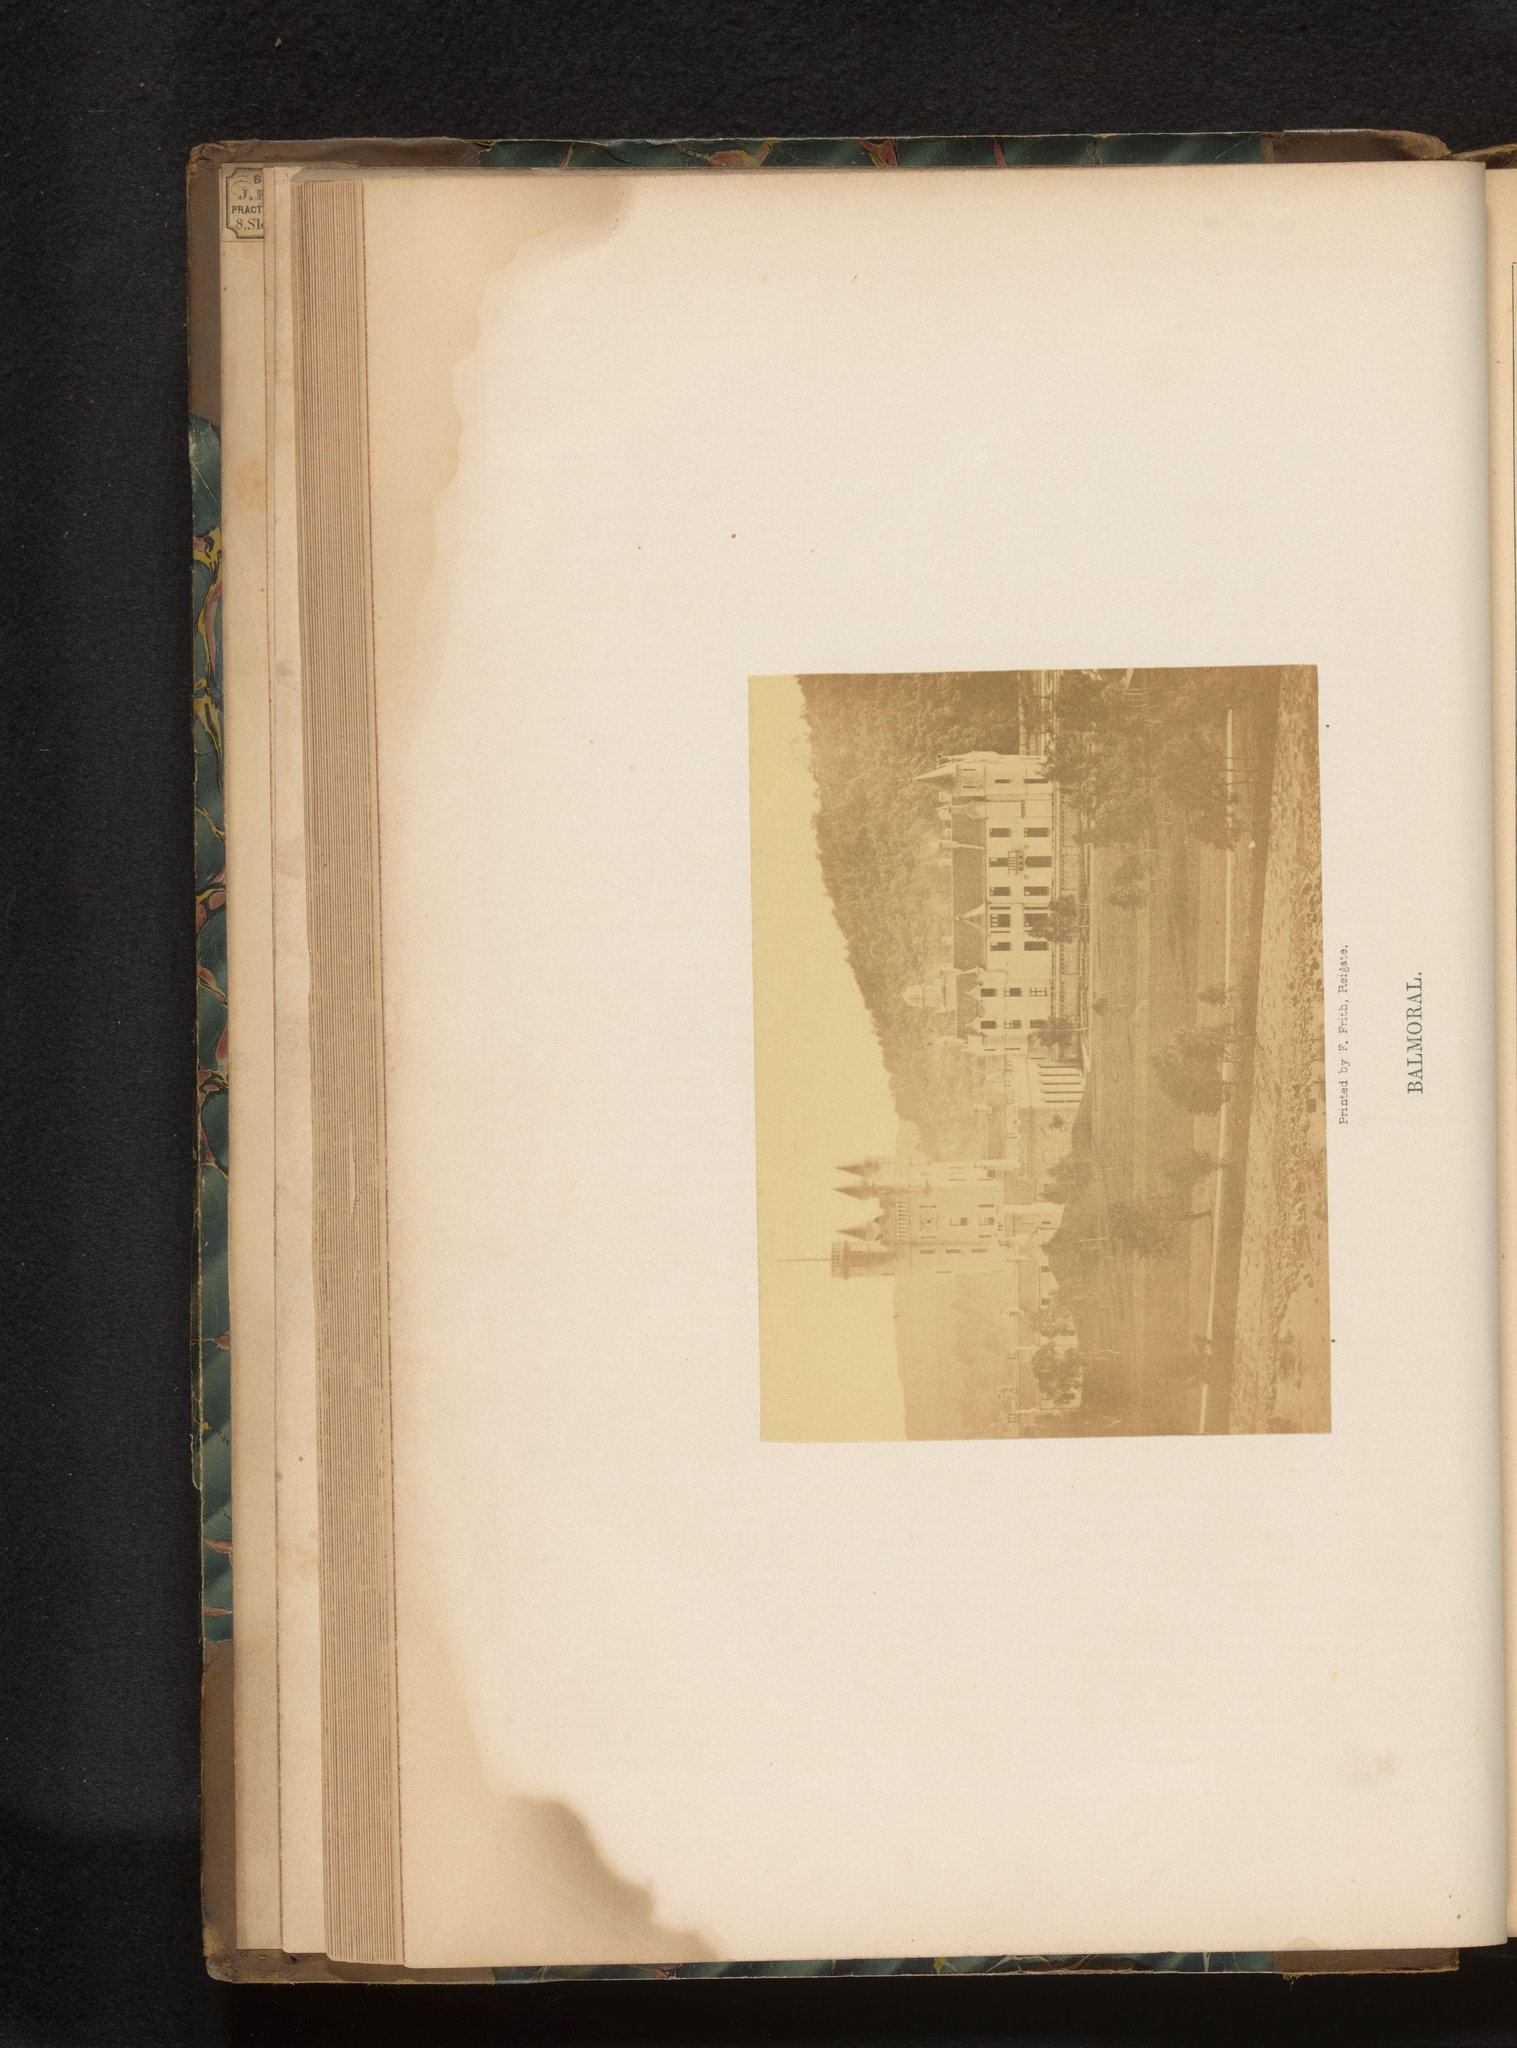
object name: page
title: Balmoral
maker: francis frith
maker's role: publisher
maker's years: 1822-1898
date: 1857-1862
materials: photographic support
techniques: albumen print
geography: scotland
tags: castle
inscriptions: inscription: ‘Printed by F. Frith, Reigate.’